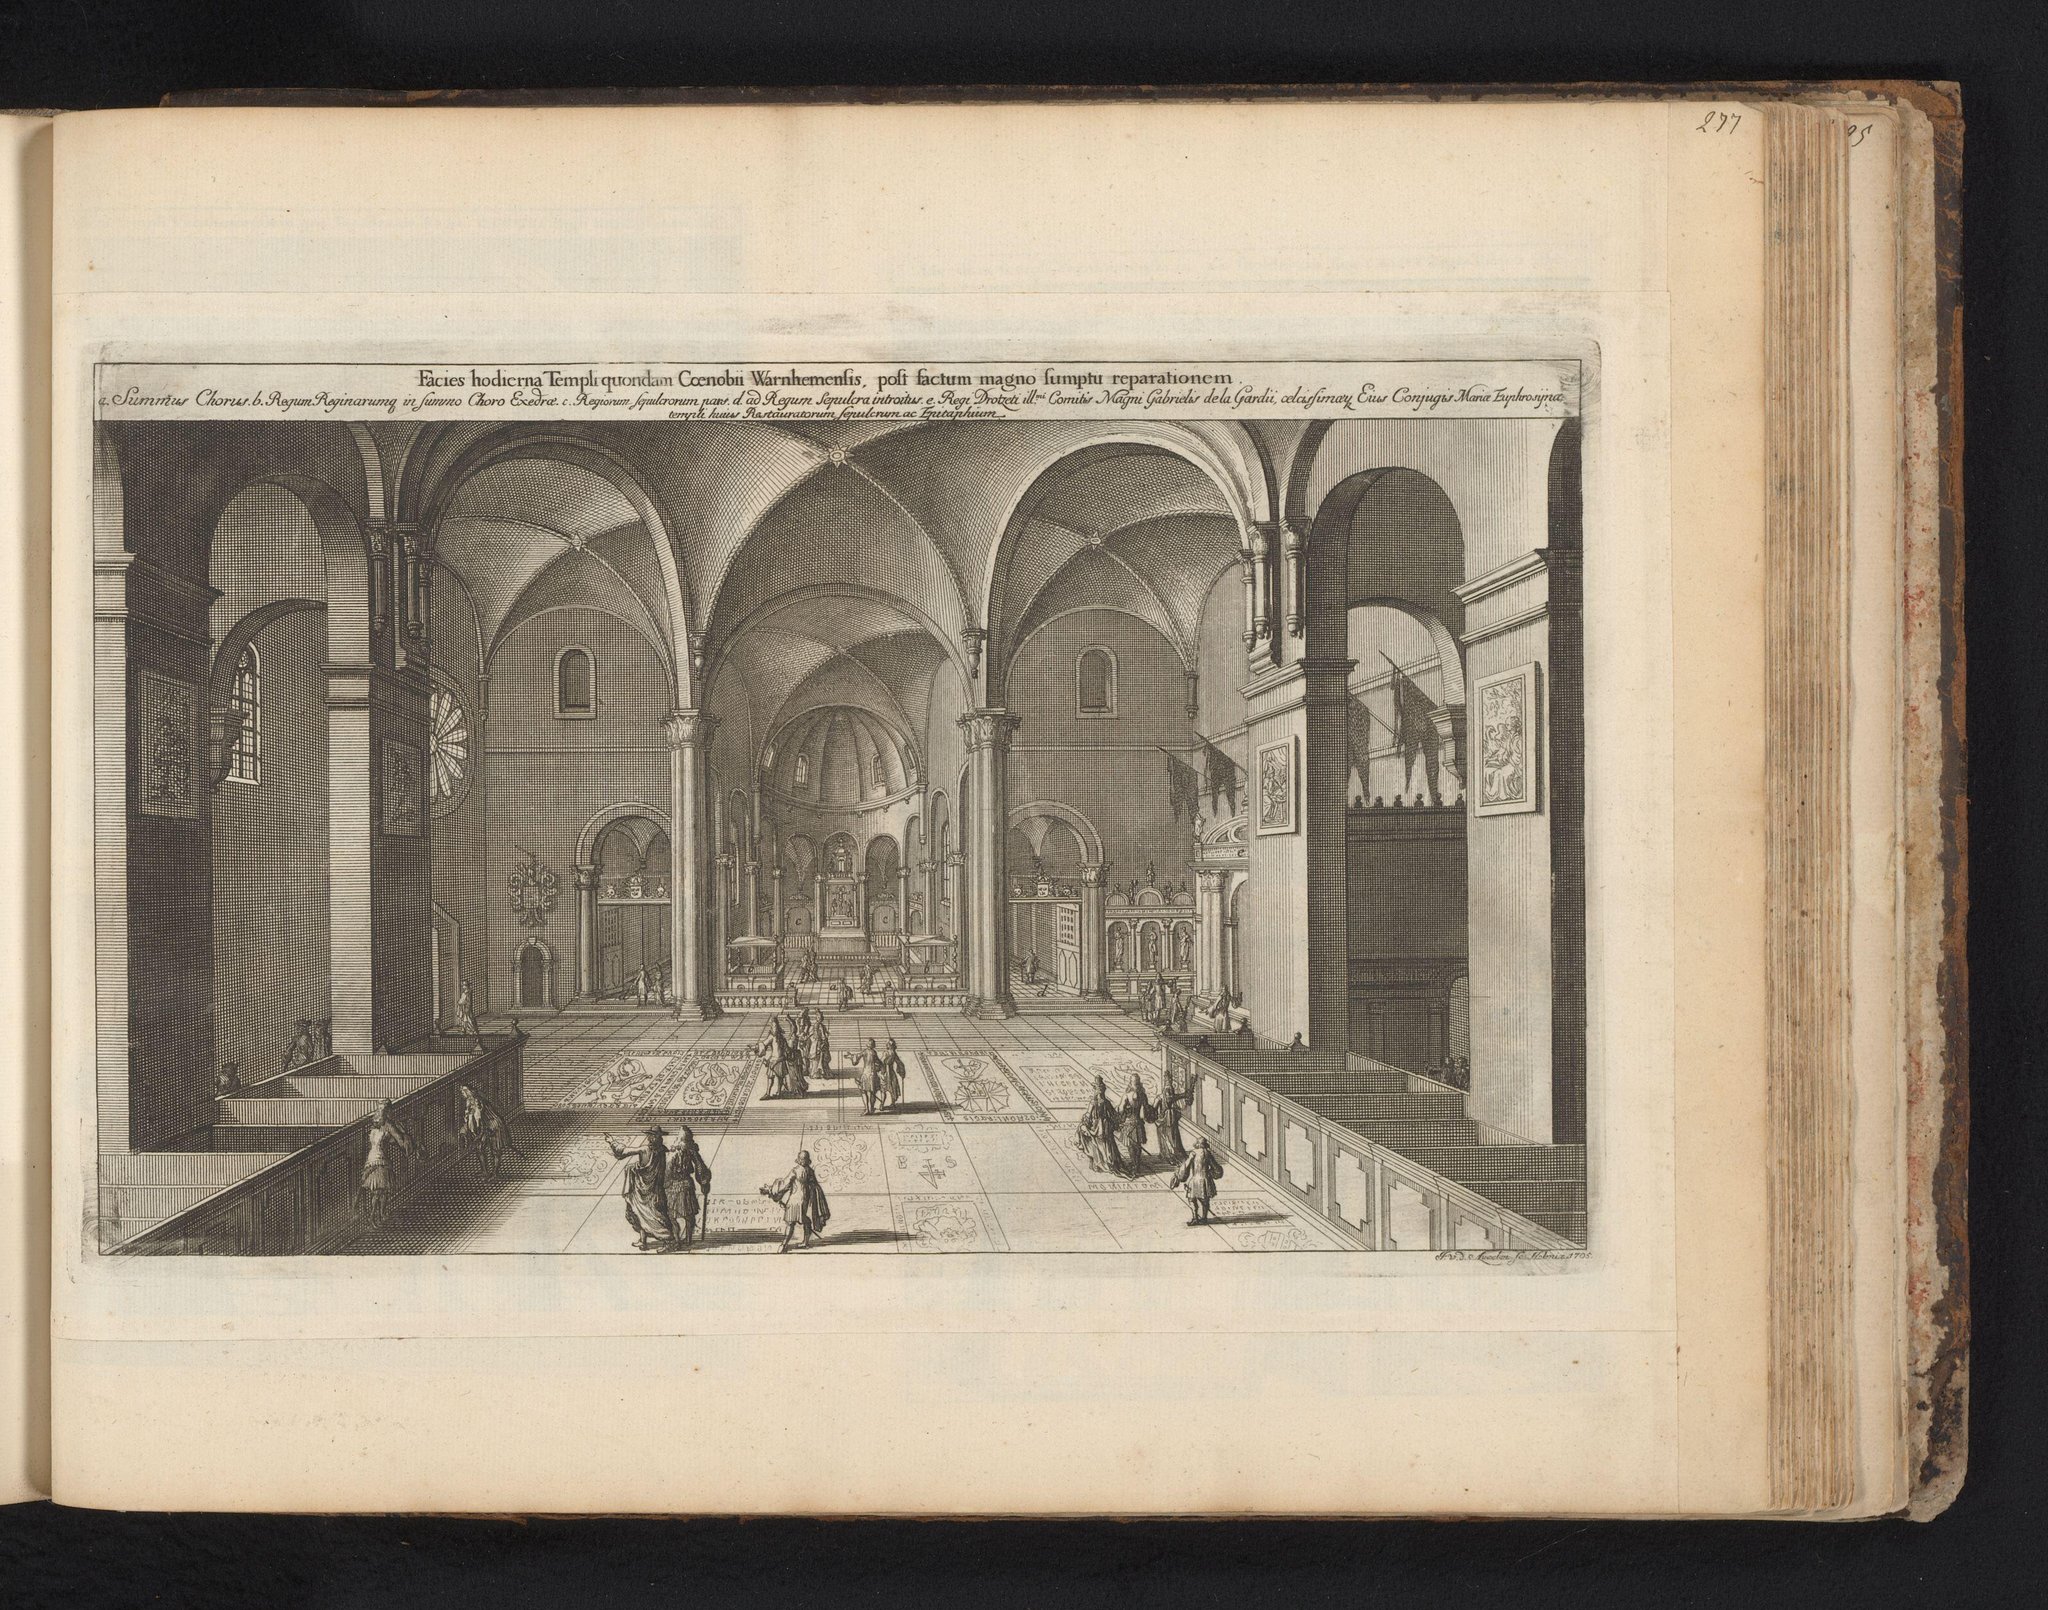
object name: album leaf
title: Interieur van de kloosterkerk van Varnhem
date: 1705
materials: paper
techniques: etching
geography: stockholm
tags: interior of church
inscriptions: date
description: Kungliga Biblioteket, 'Suecia': http://www.kb.se/samlingarna/Kartor-bilder/Suecia-antiqua/ (geraadpleegd november 2016).